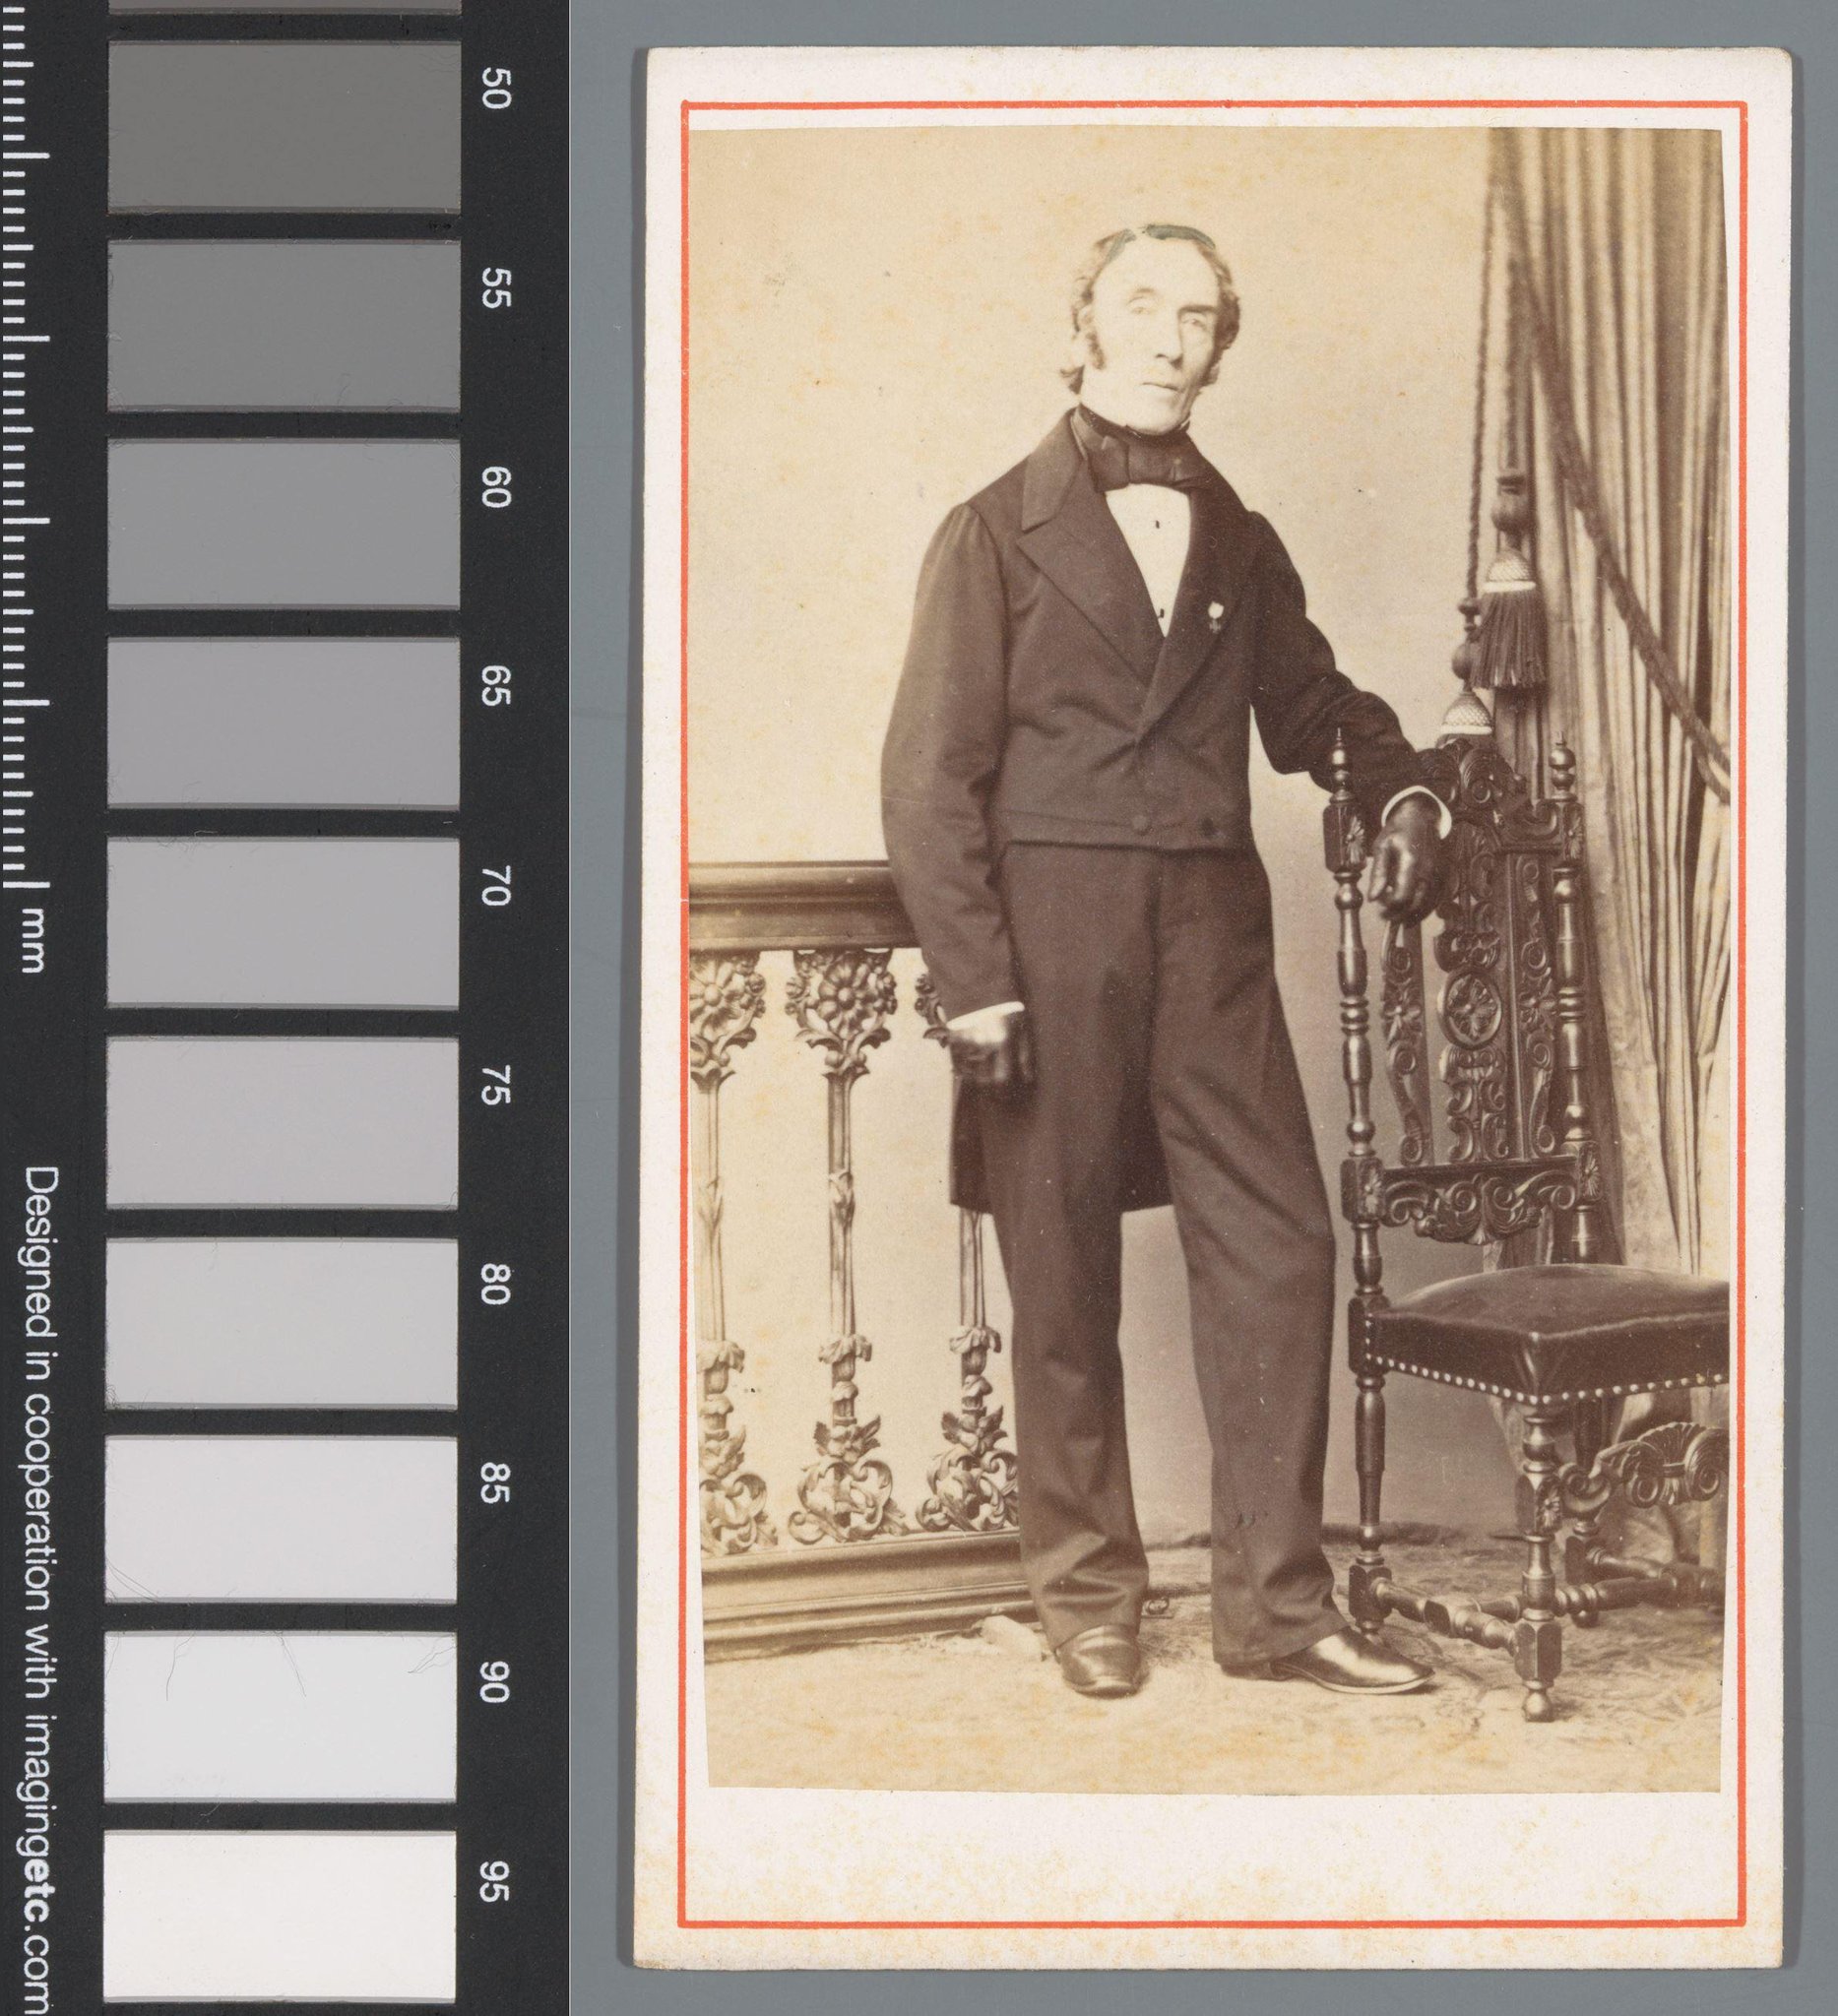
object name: carte de visite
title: Portret van een onbekende man, staande naast een stoel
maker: Anonymous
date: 1855-1885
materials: cardboard, paper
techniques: albumen print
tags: adult man, historical persons